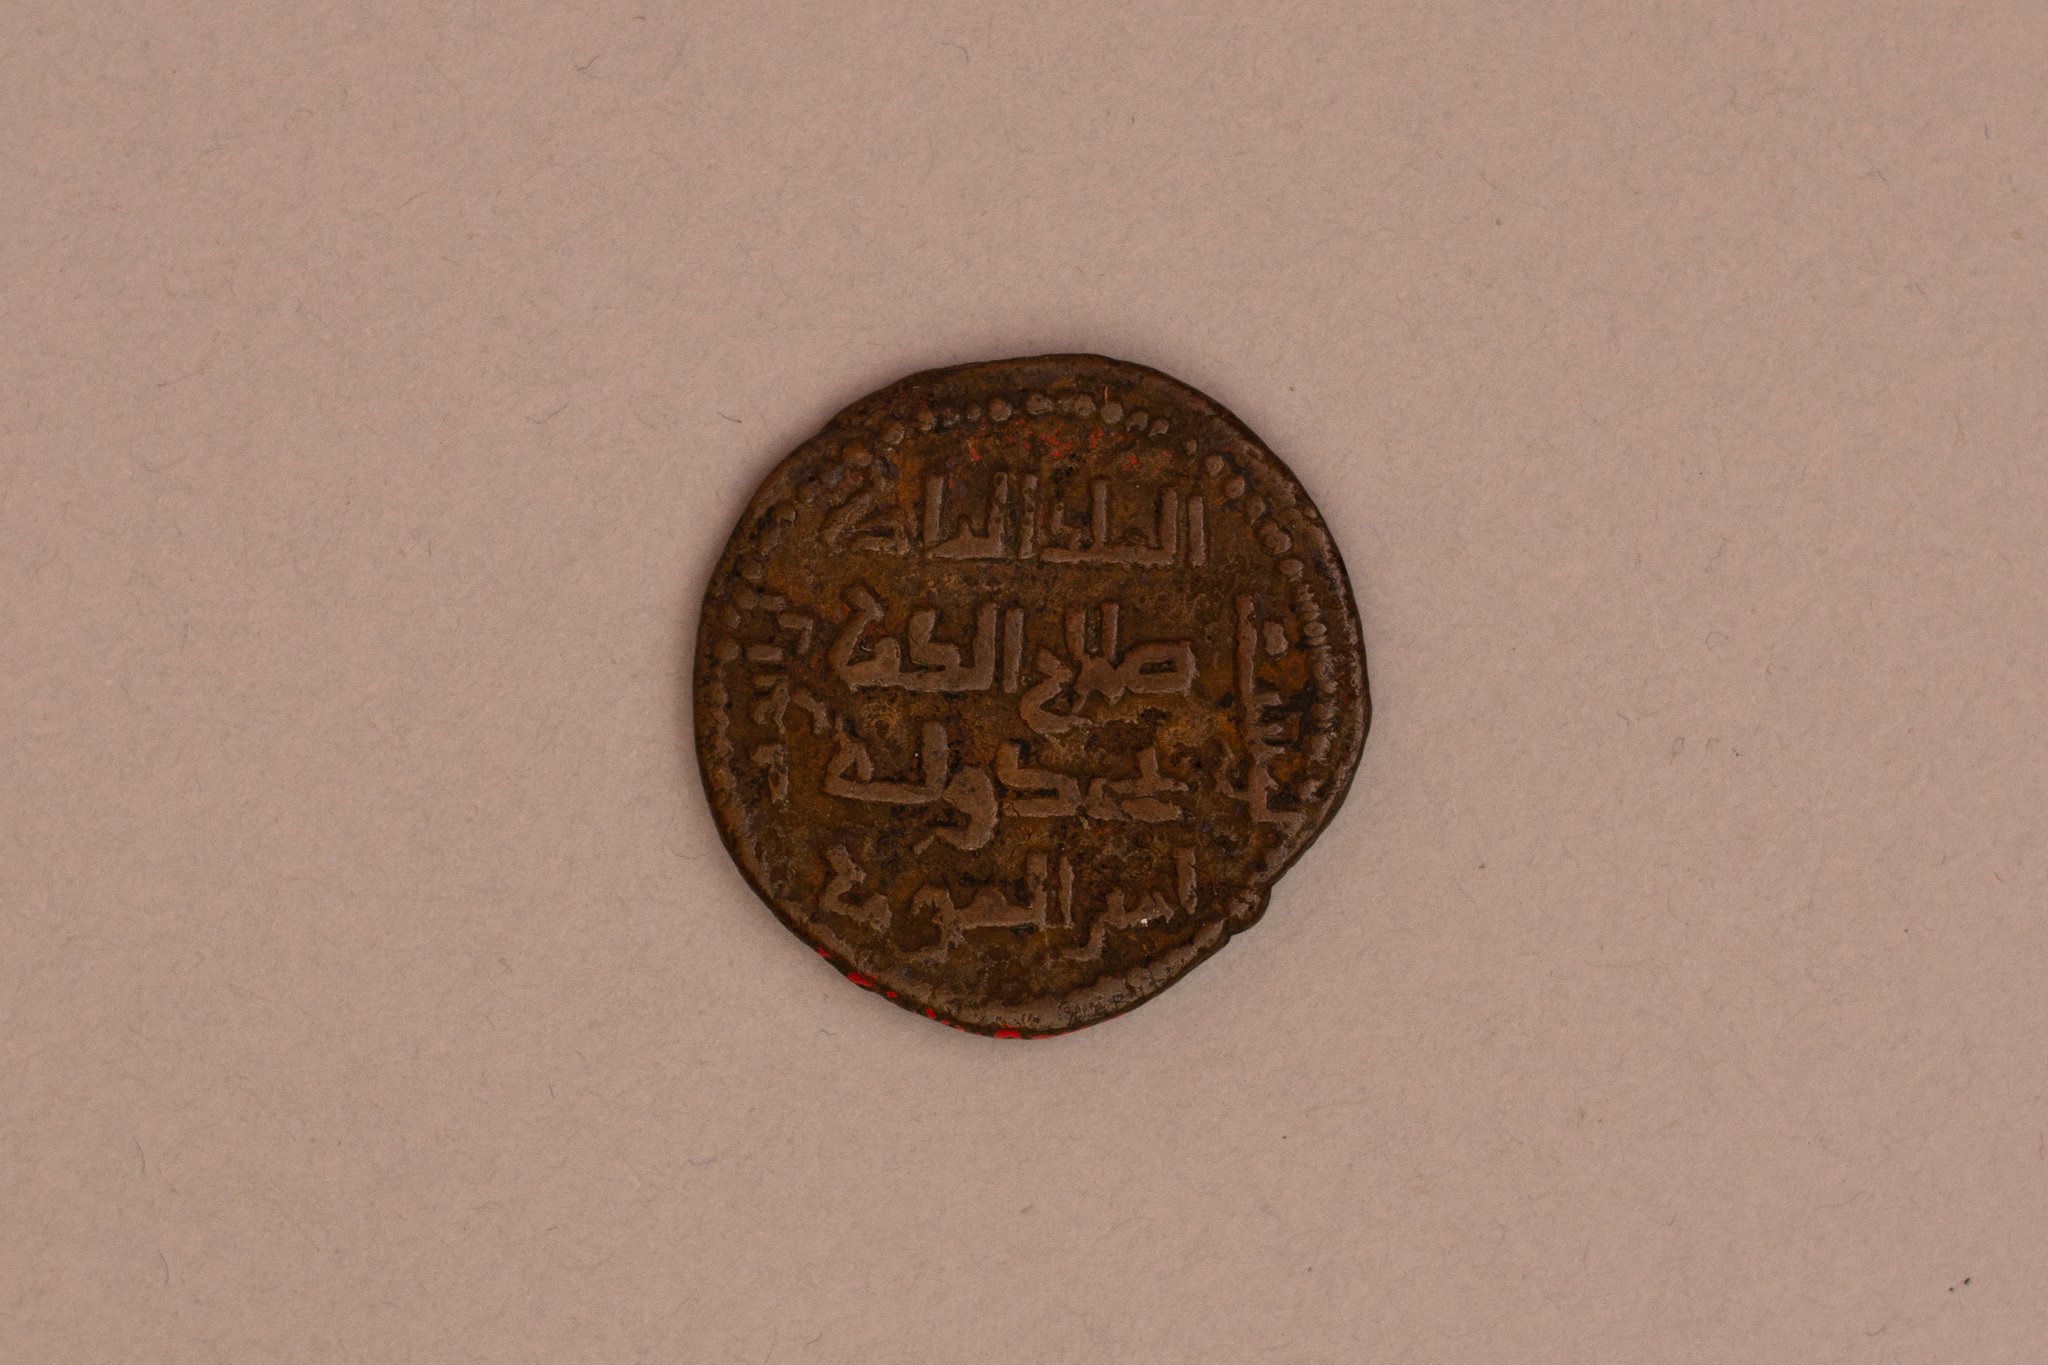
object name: coin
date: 1101-1200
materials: copper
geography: iraq